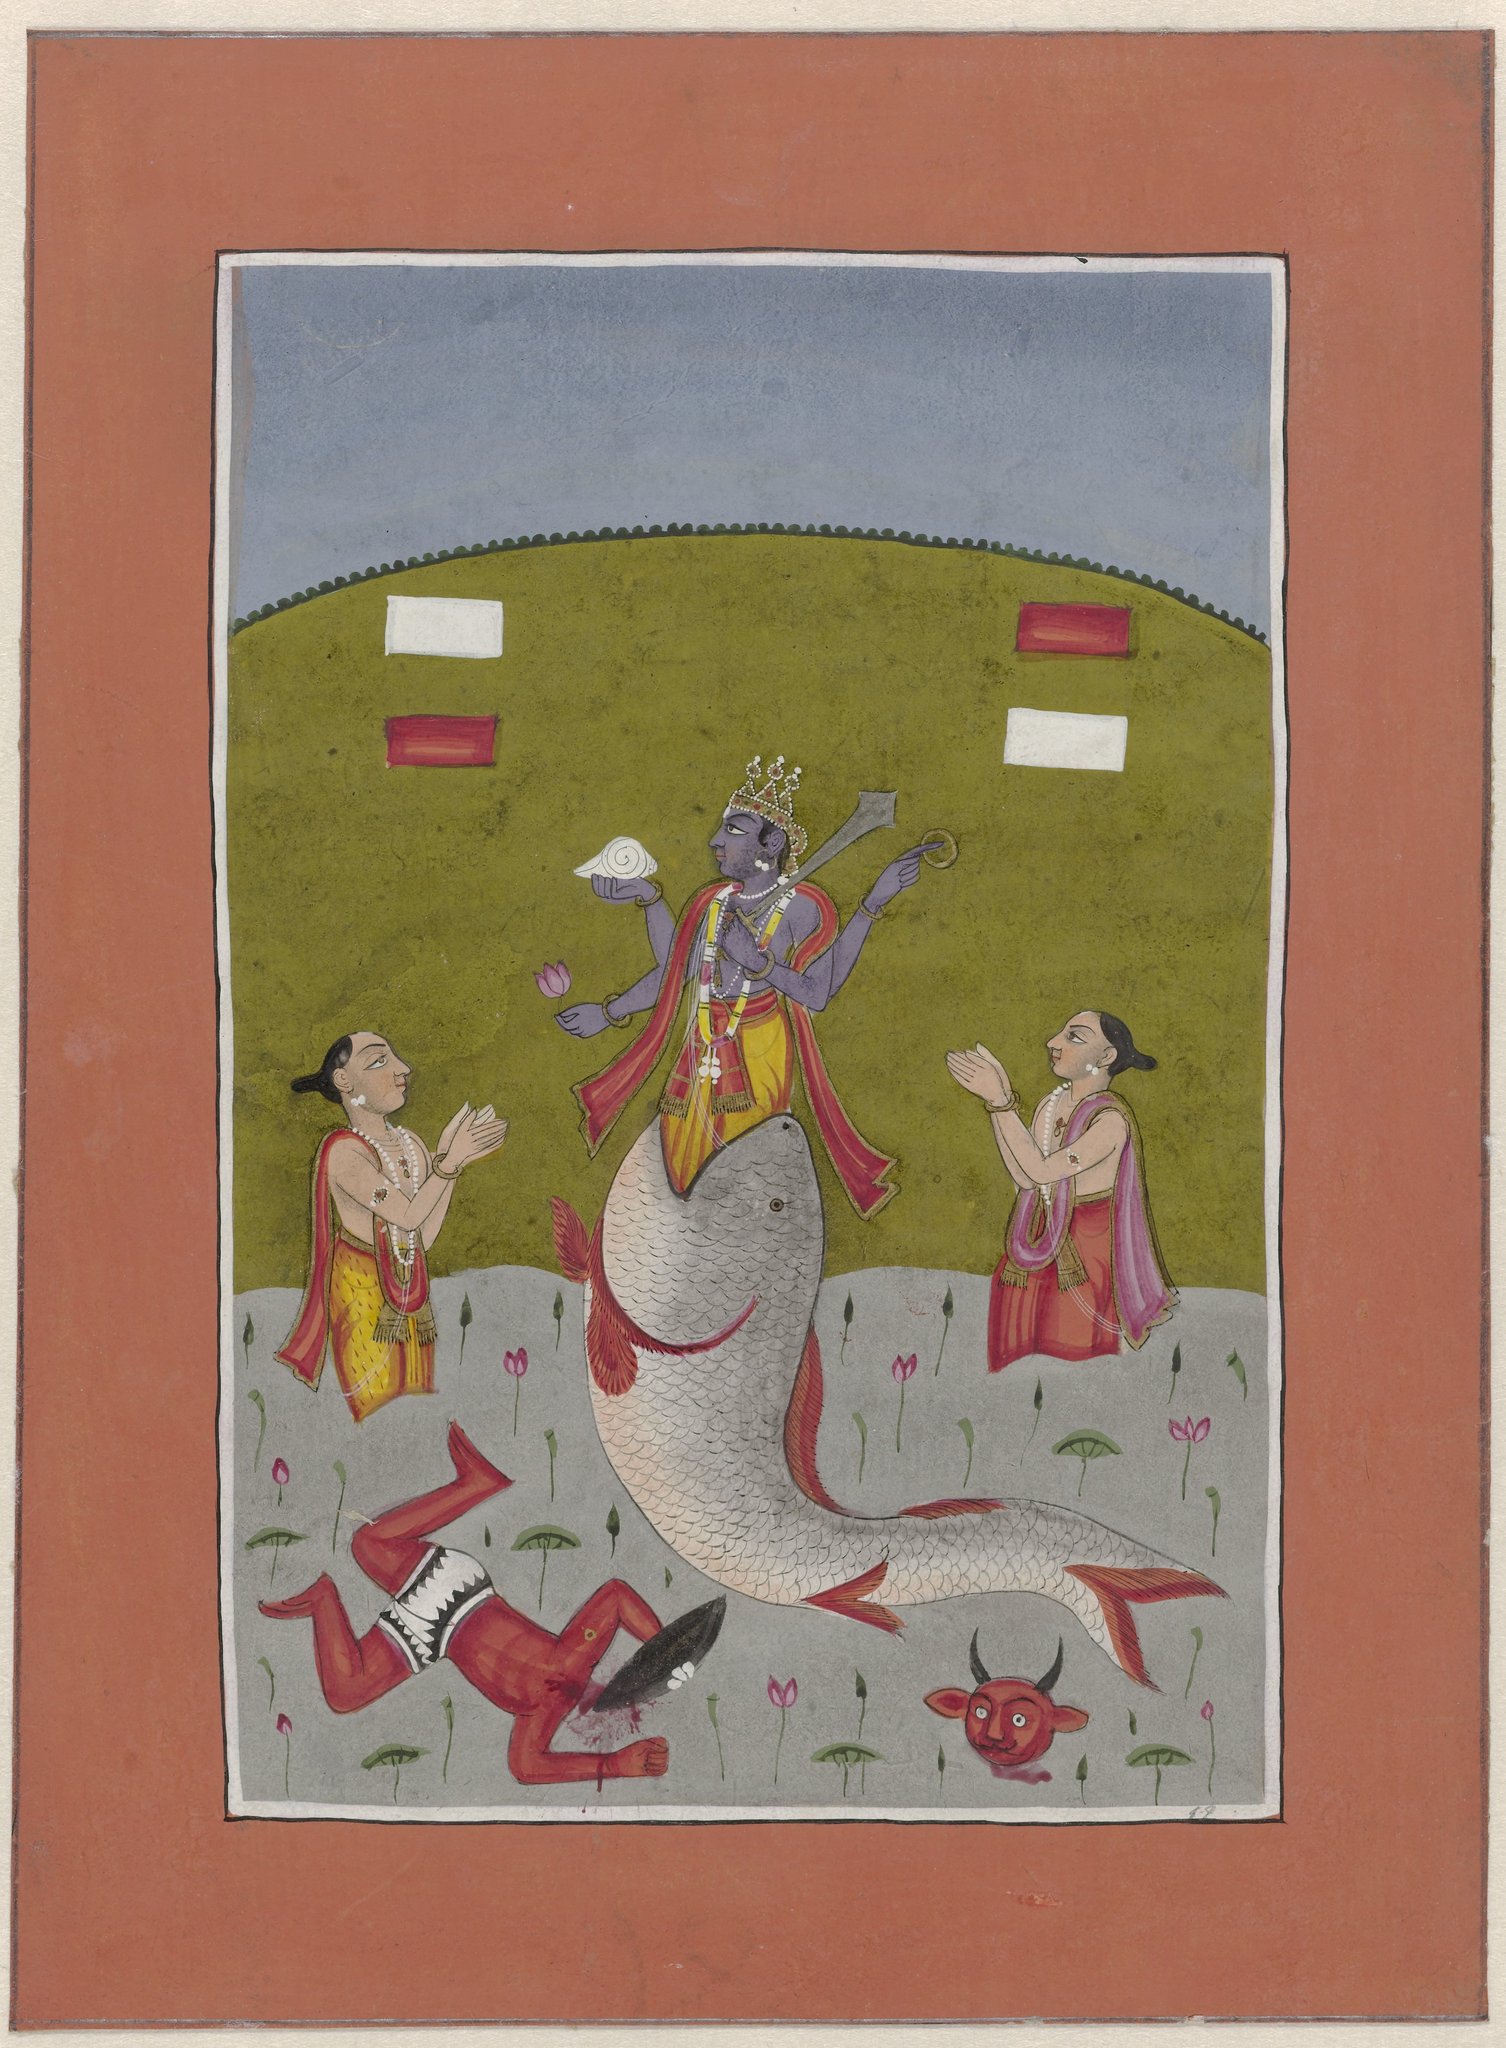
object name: drawing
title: Avatars van Vishnu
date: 1825-1875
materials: paper, watercolor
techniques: brush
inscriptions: inscription: ‘64’, inscription: ‘1st// Fish Avatar’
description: Vishnu daalt neer in de bek van een vis. De voorstelling is omlijst door een smal wit biesje, daaromheen een brede oranjerode sierrand met zwarte kaderlijnen; dit blad is op een blad kardoespapier opgeplakt waarop een zwarte kaderlijn in potlood is getekend.